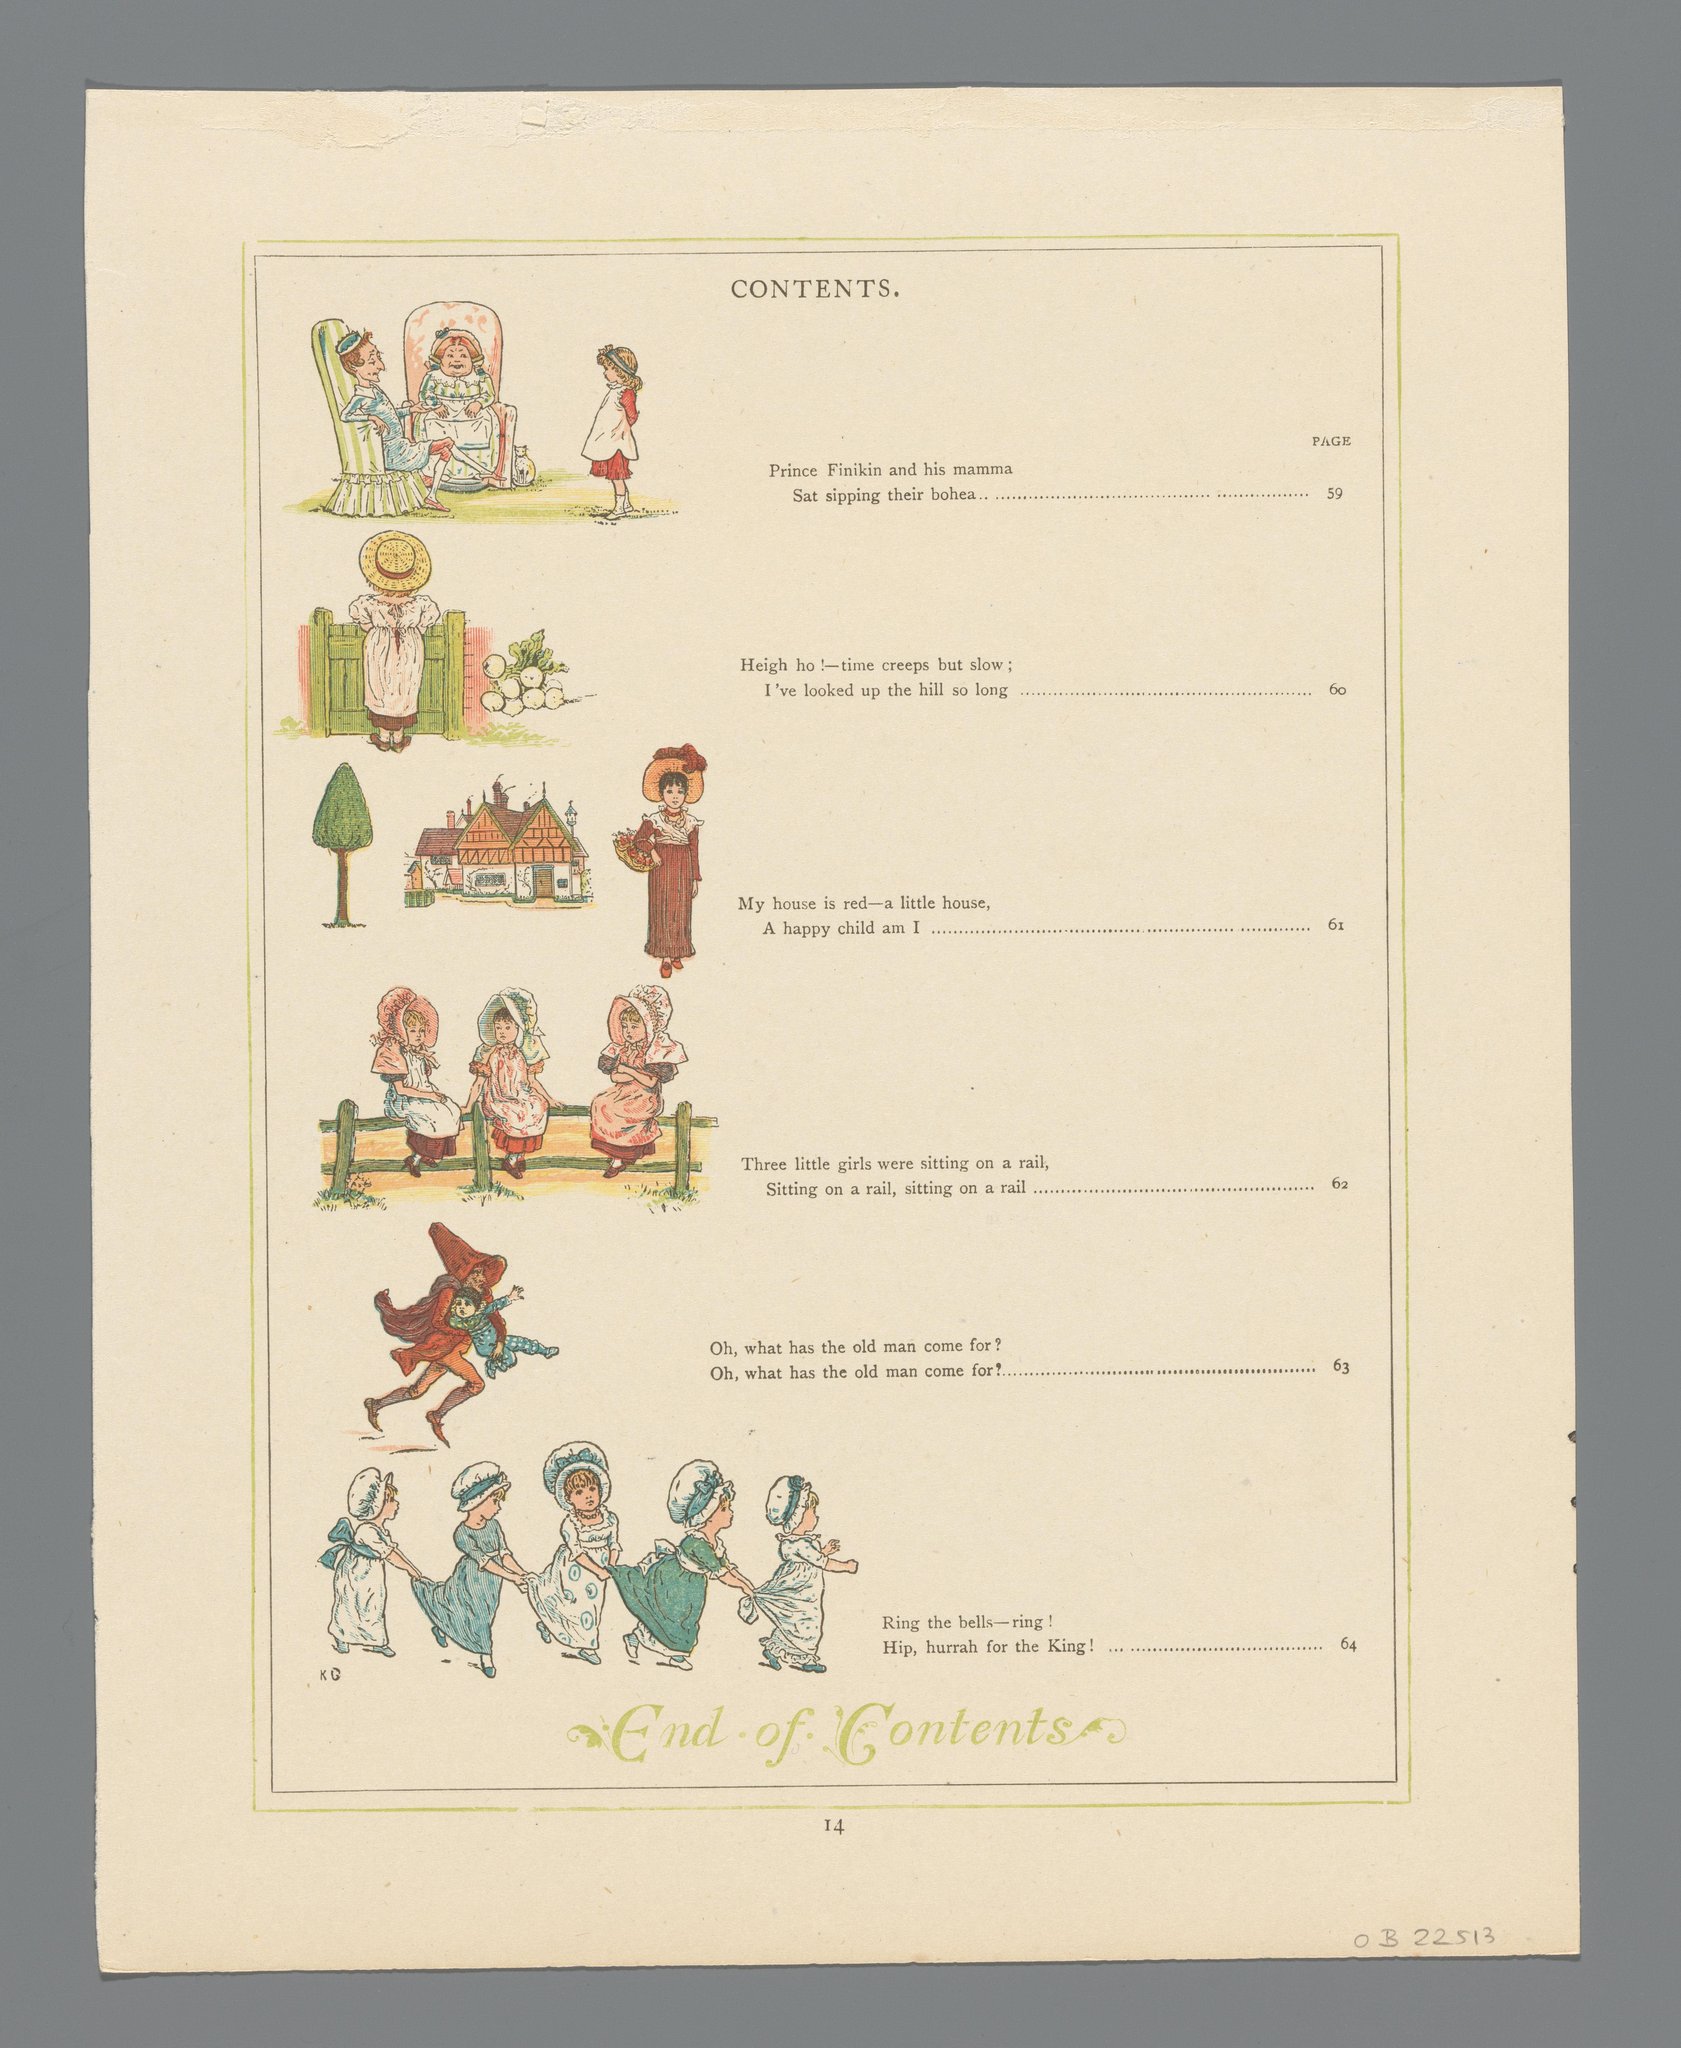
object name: book illustration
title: Zes voorstellingen met spelende kinderen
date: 1878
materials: paper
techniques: wood engraving, letterpress printing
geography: london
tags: children's games and plays, child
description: Prent uit: Greenaway, Kate. Under the window, pictures & rhymes for children. Londen: George Routledge & Sons, 1878, p. 14.